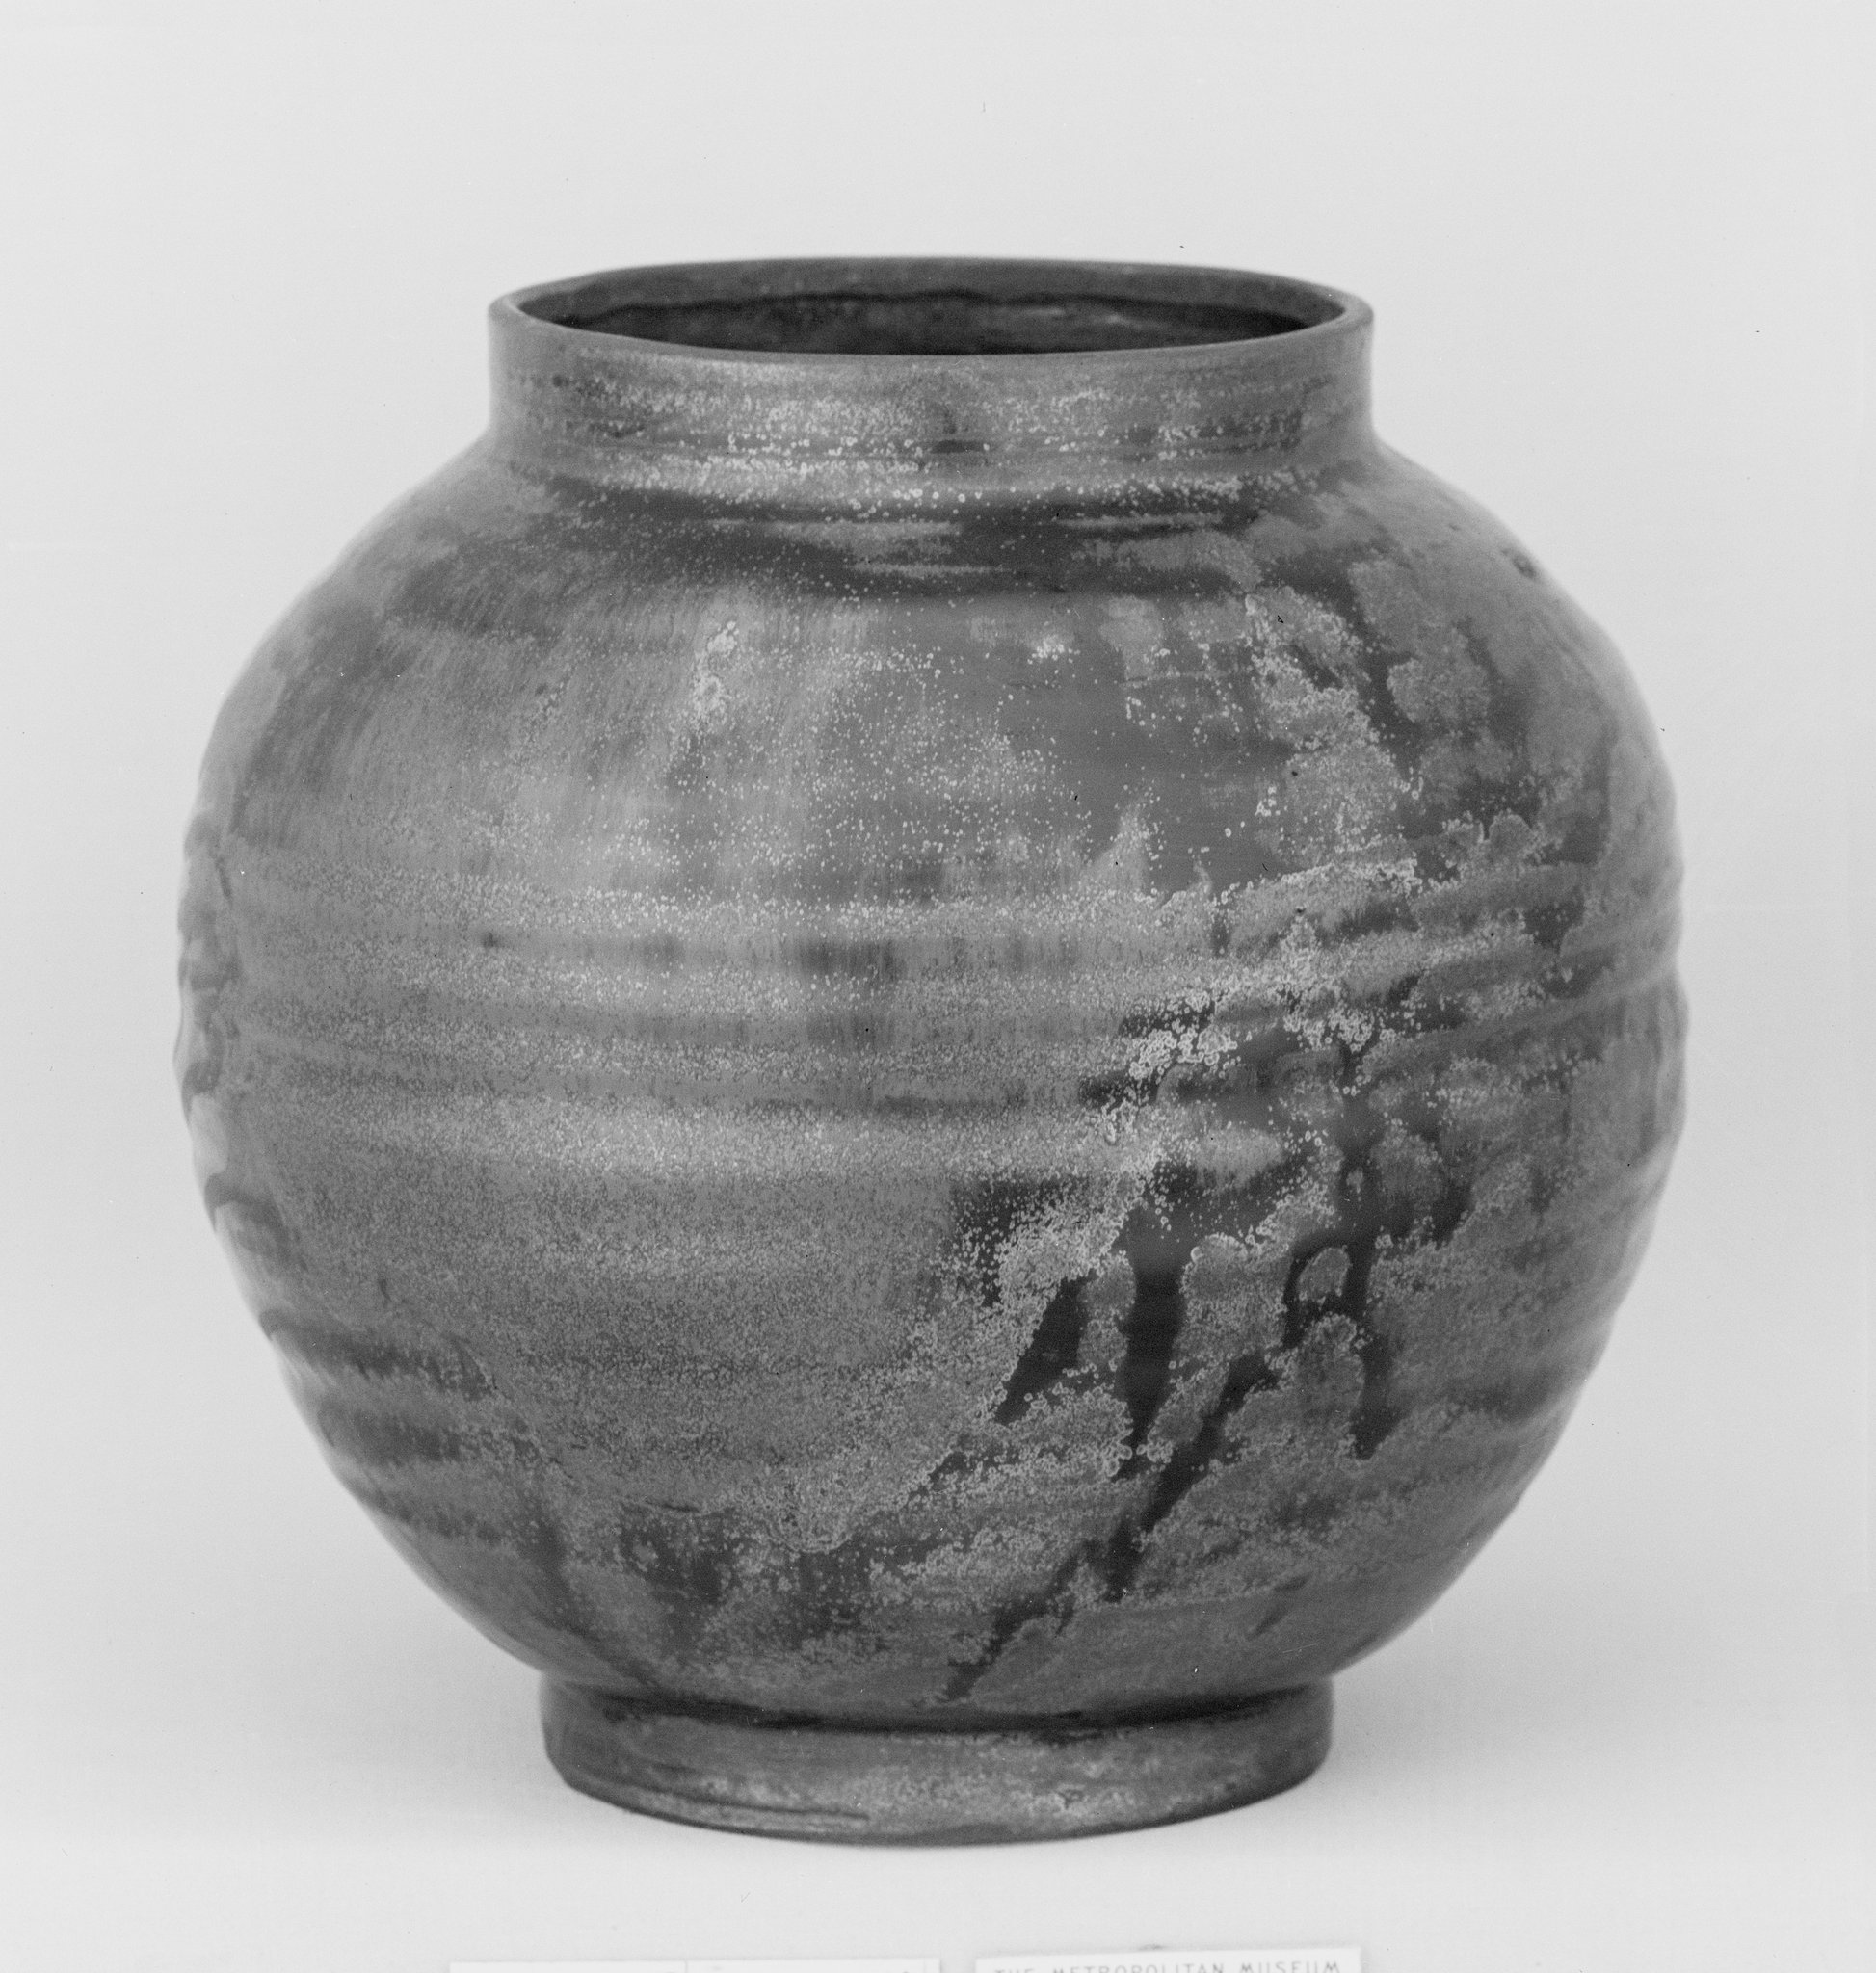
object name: vase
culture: japanese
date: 1701-1800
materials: glaze, pottery